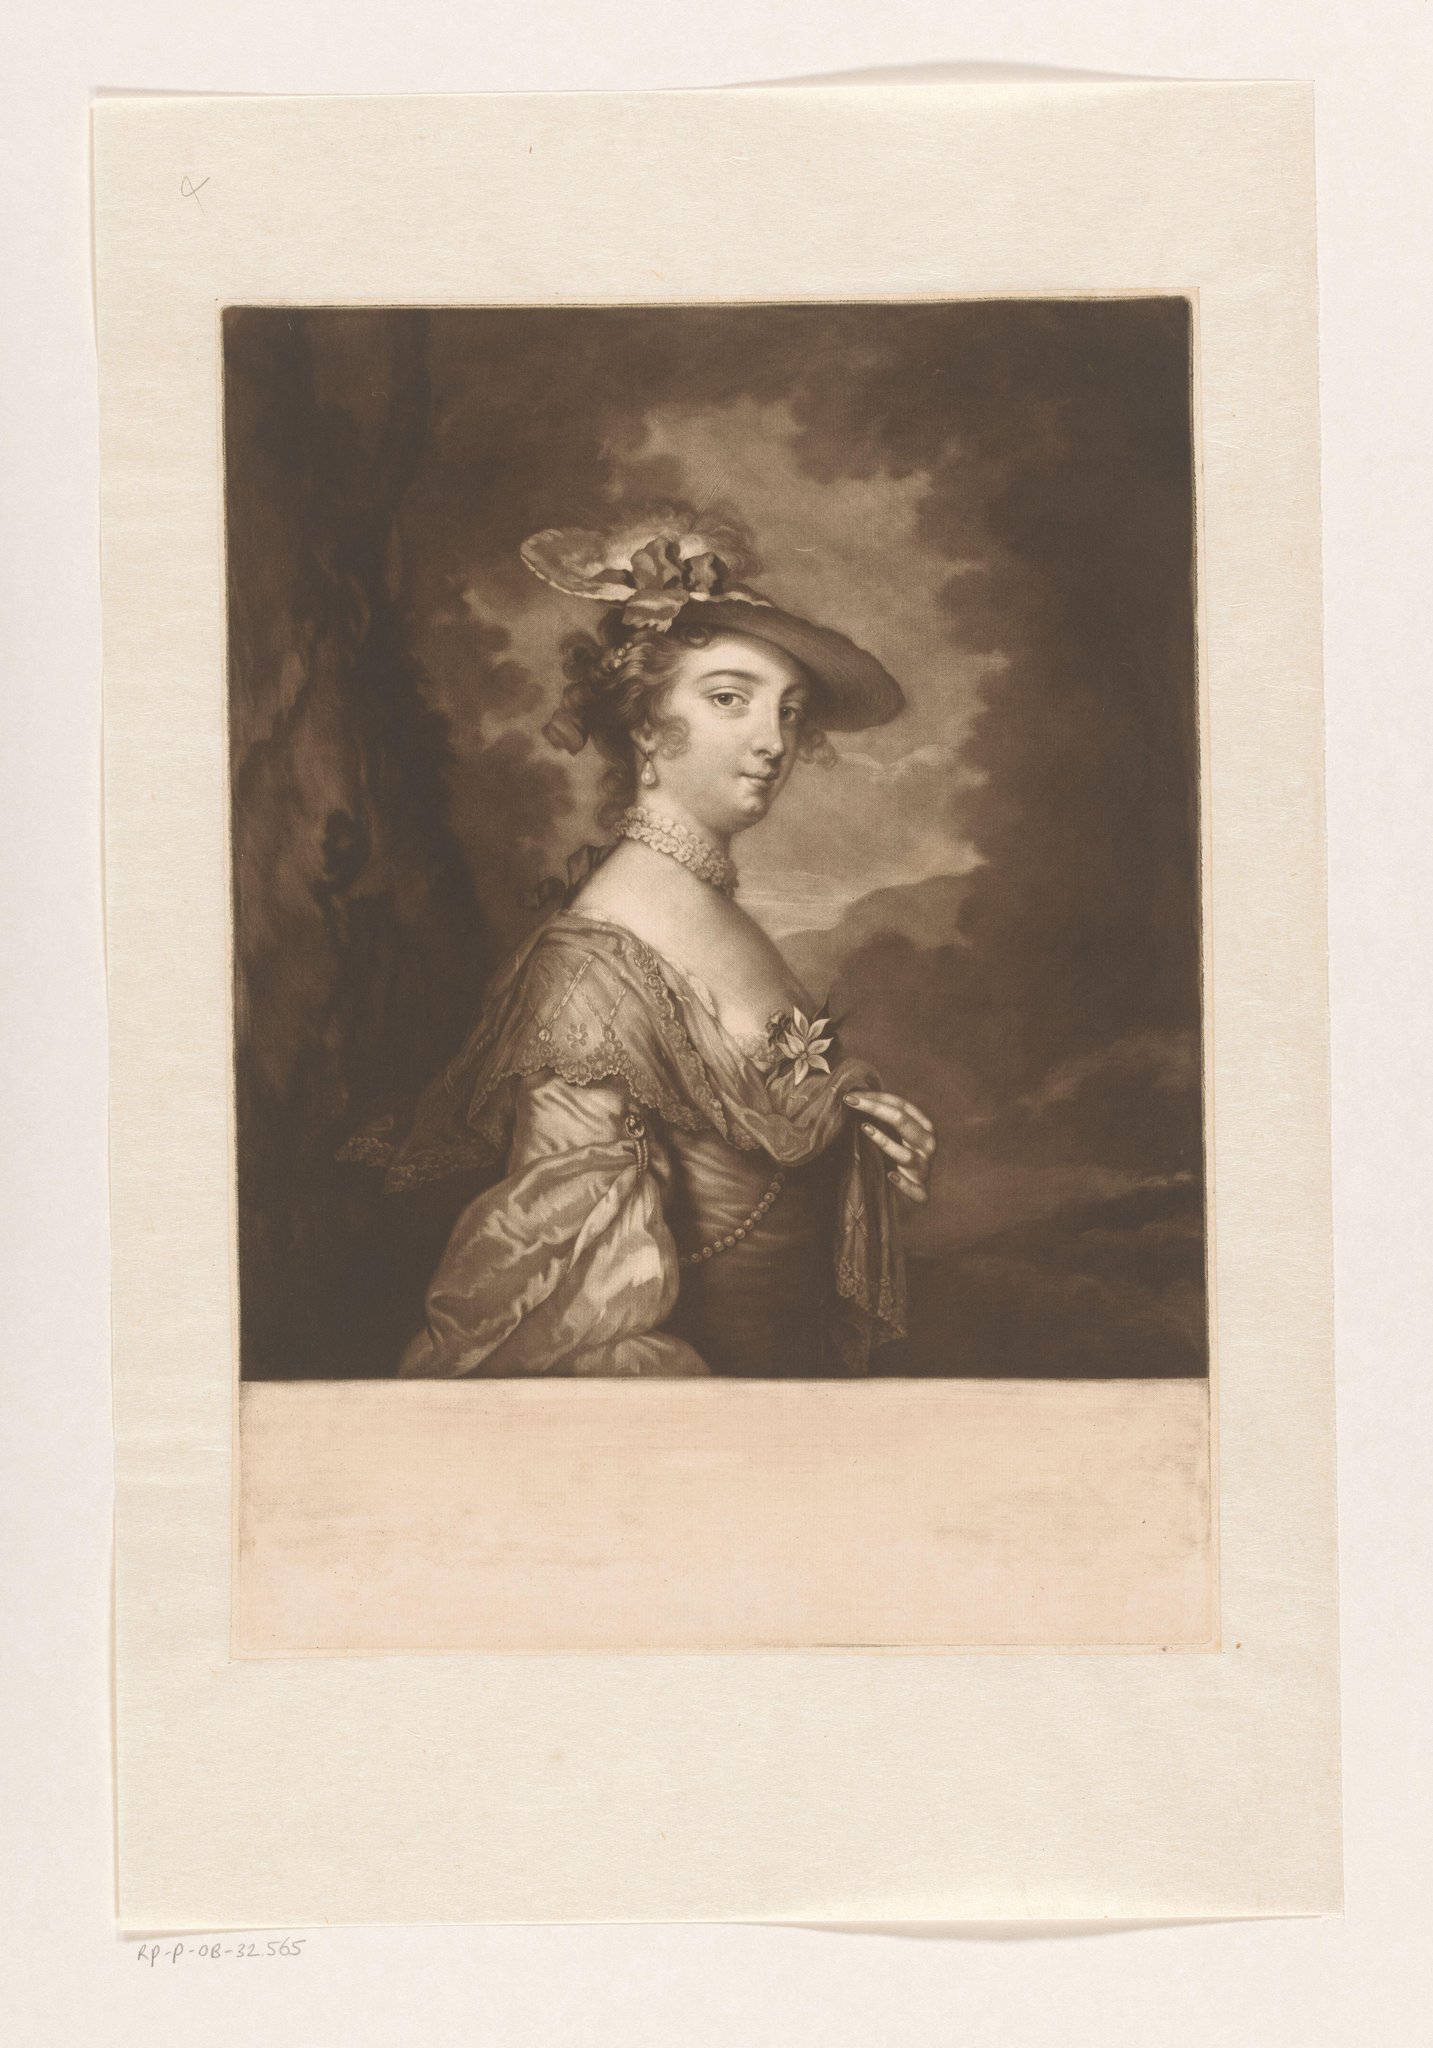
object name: print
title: Portret van een vrouw met schuine hoed en pareloorbel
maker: james mcardell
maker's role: print maker, publisher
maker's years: 1728-1765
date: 1750-1765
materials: paper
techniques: mezzotint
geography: london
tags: cut flowers; nosegay, bunch of flowers, anonymous historical person portrayed alone - bb - woman, head-gear: hat, ear-rings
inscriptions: collector's mark: Lugt 240